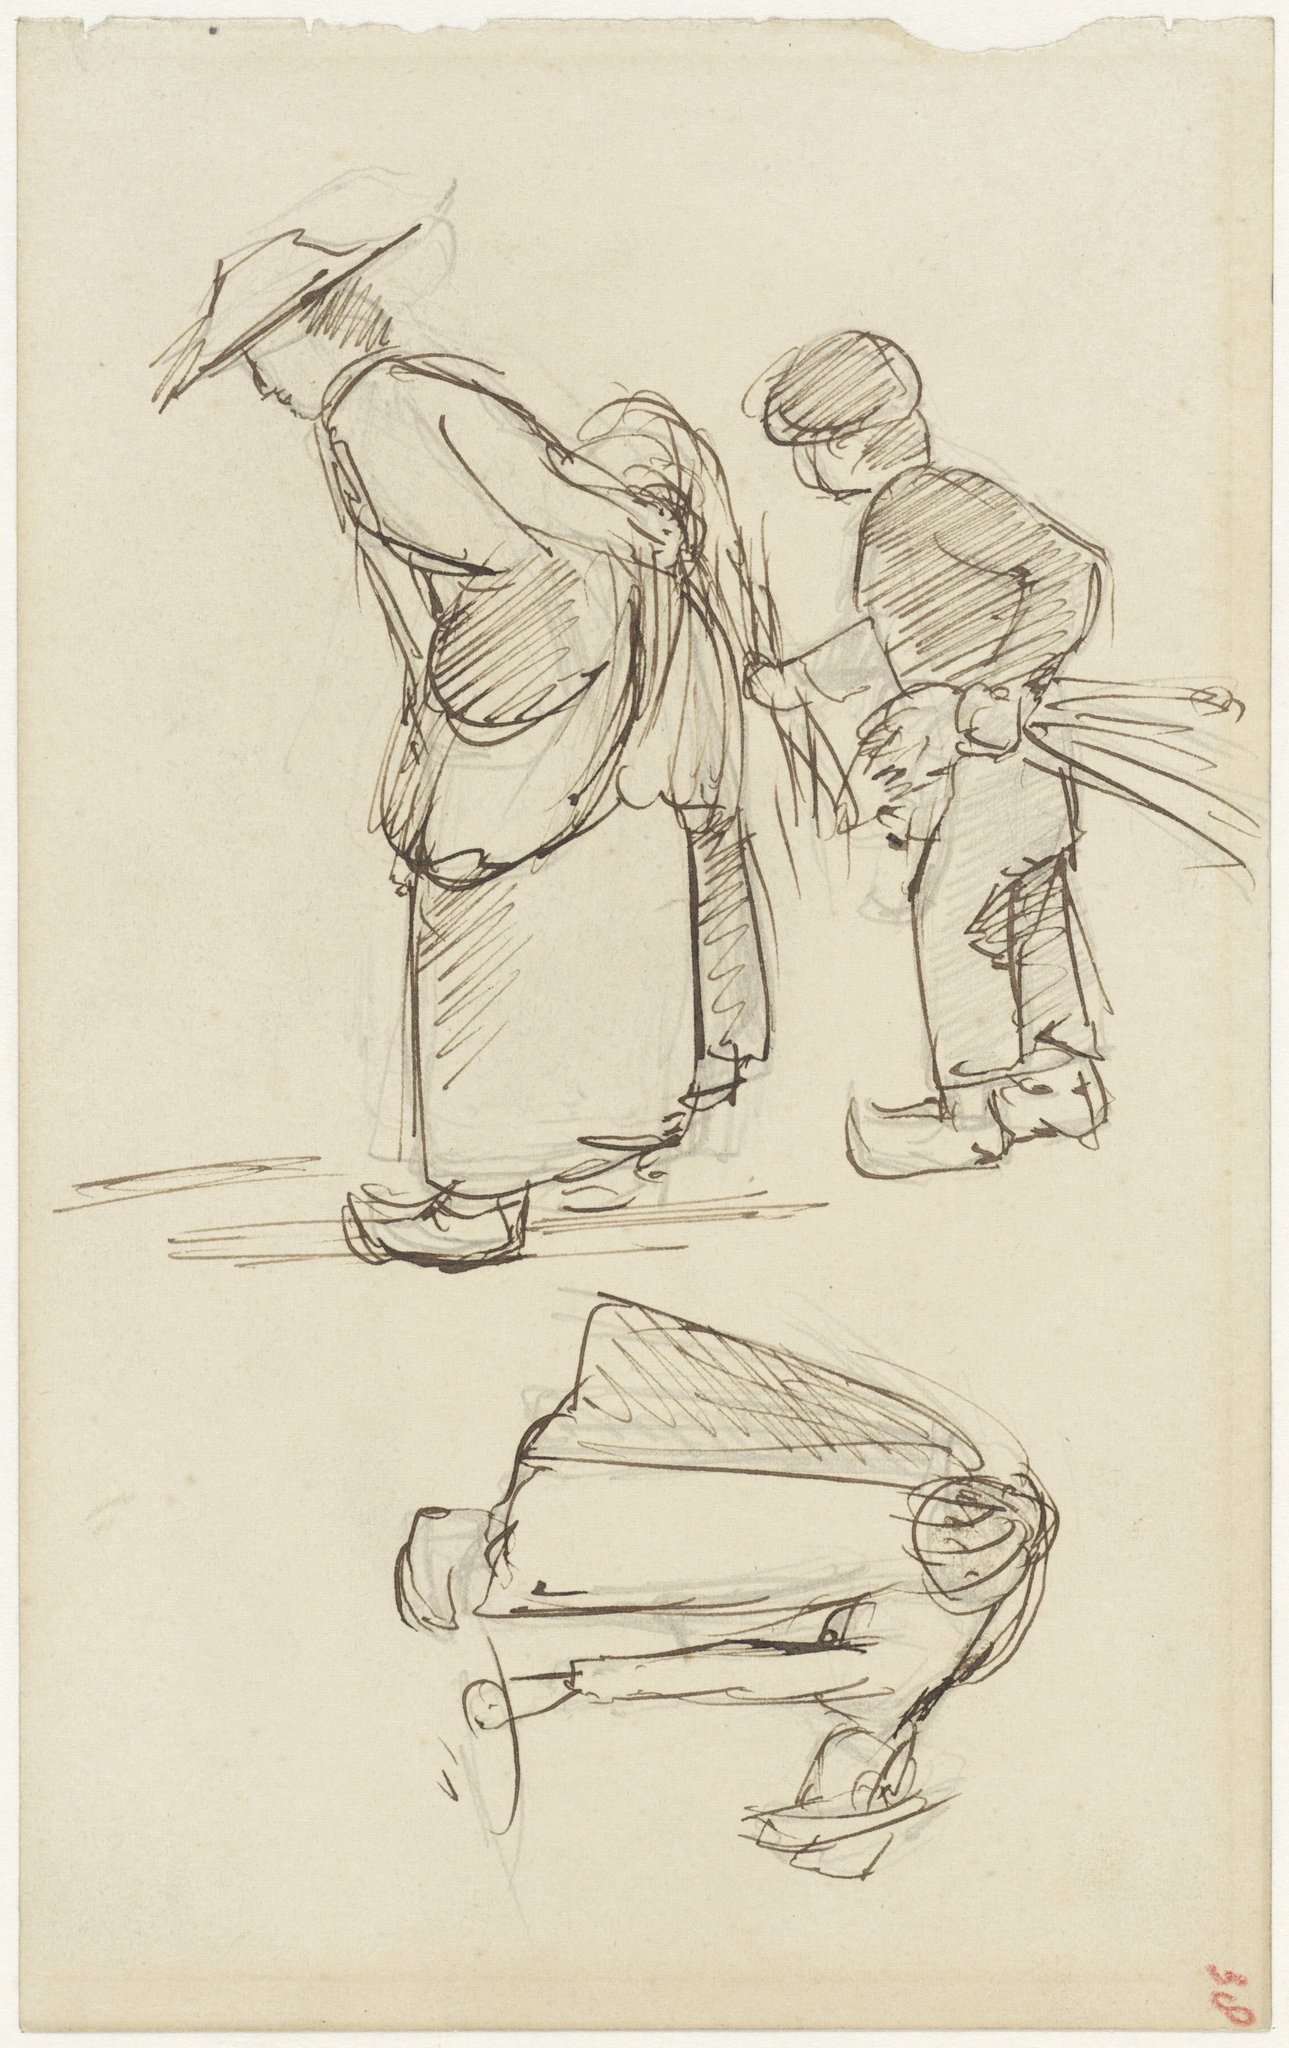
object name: drawing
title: Twee studies van een werkende vrouw en een jongen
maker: jozef israëls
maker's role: draughtsman, painter, print maker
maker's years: 1824-1911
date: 1834-1911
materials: ink, paper, pencil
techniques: pen